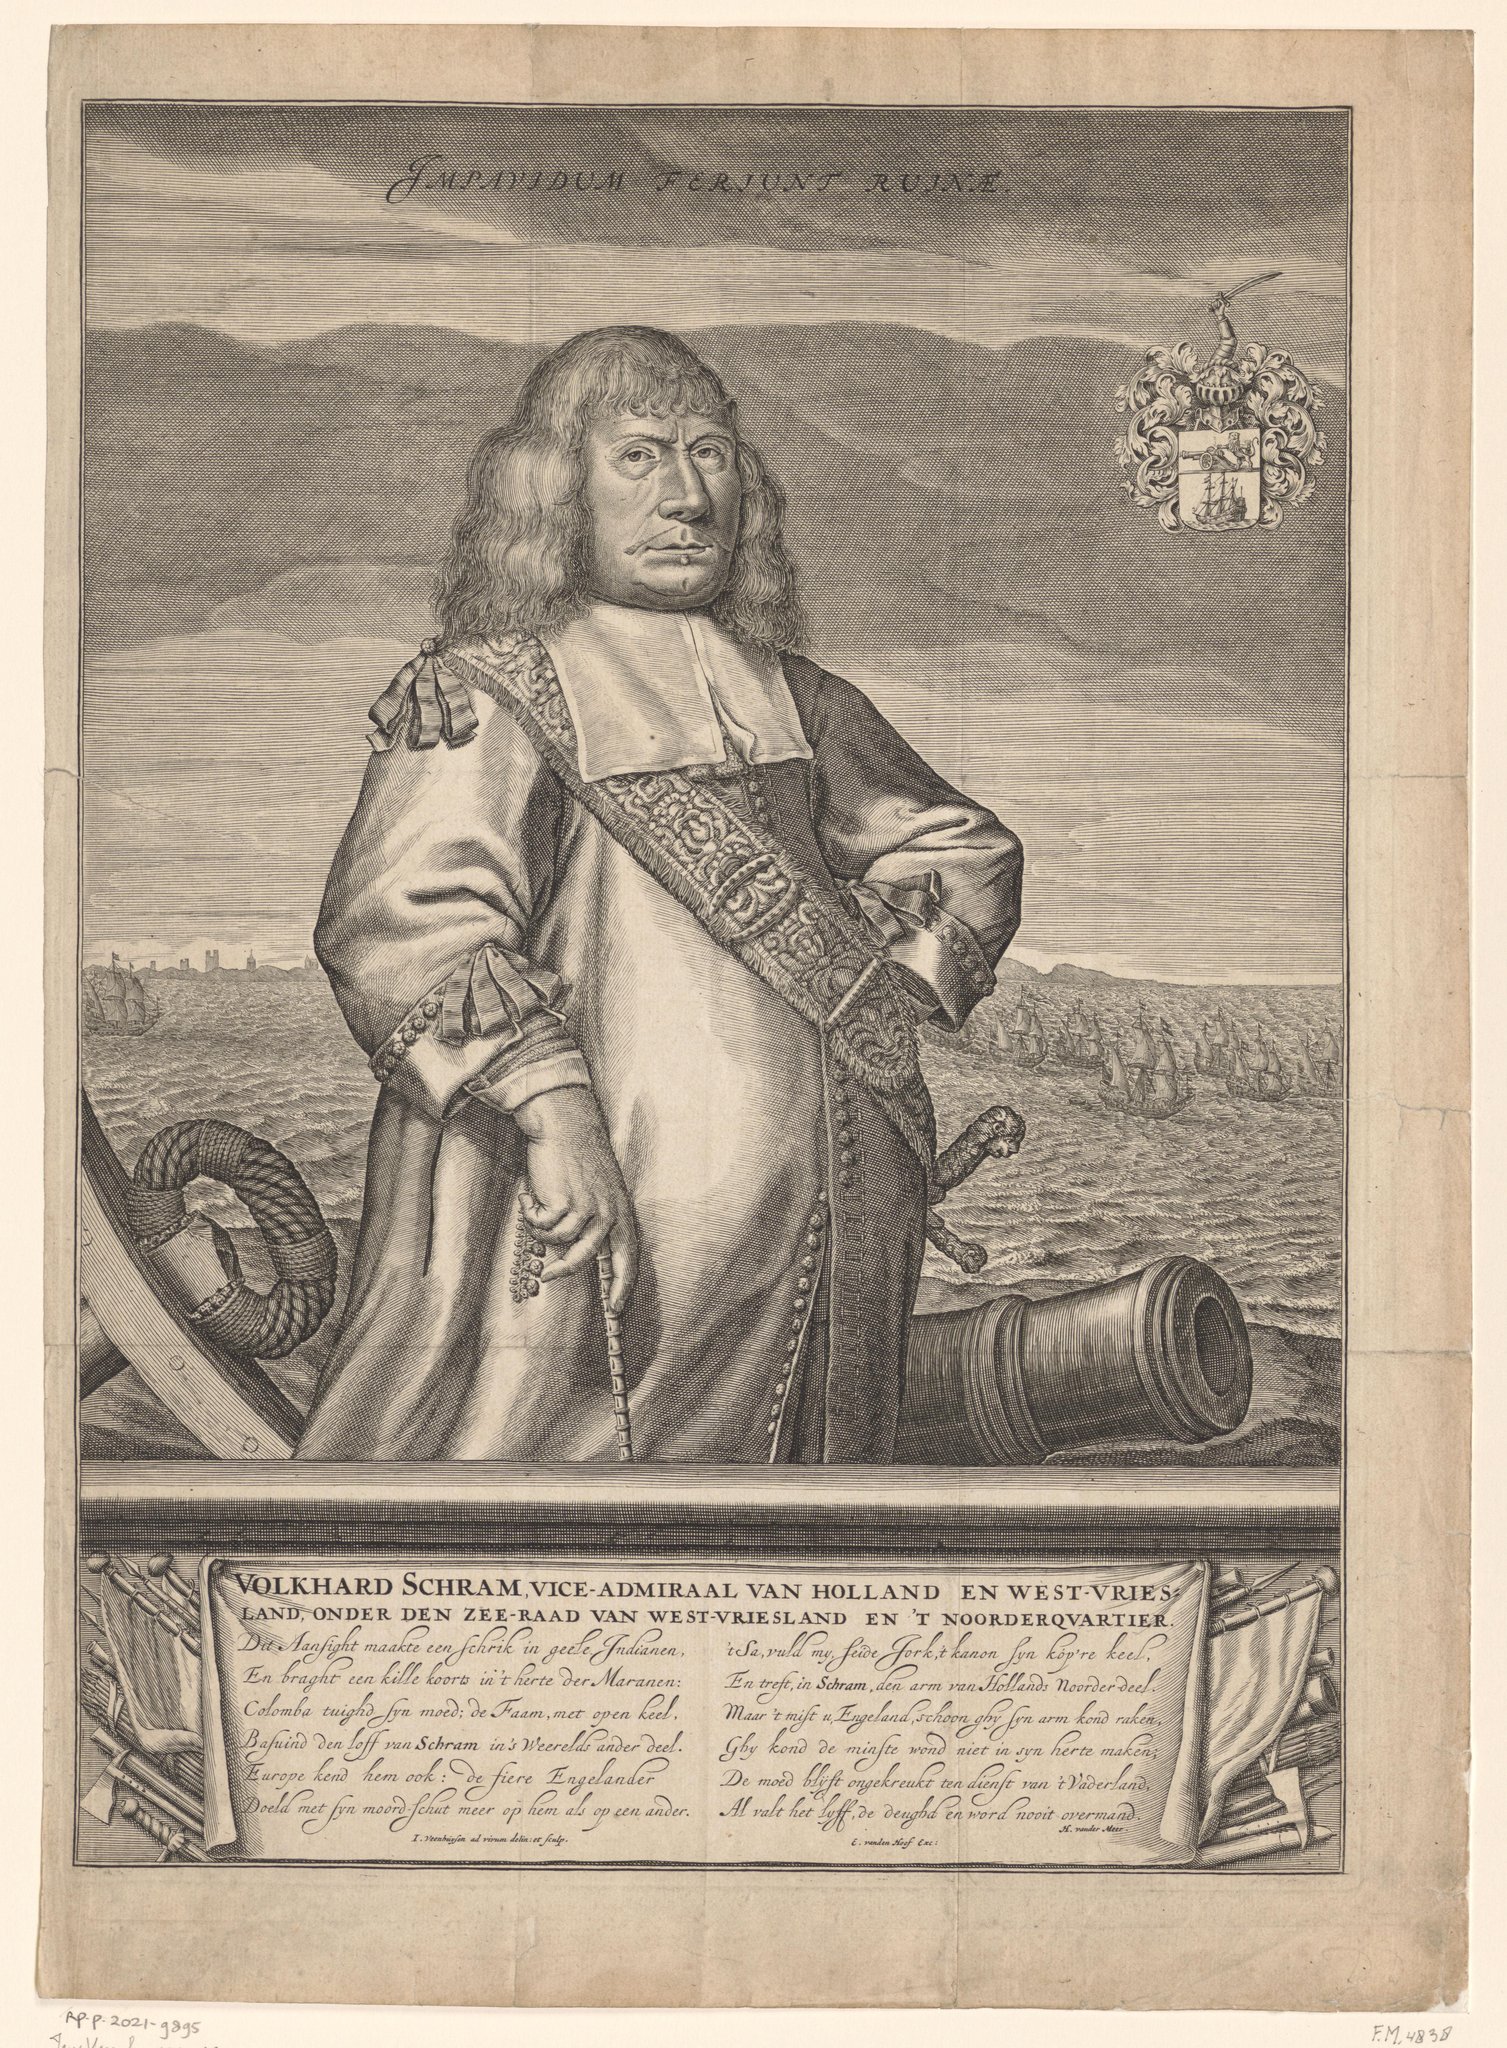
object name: print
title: Portret van Volkert Schram, Vice-admiraal van Holland en West-Friesland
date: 1655-1672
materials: paper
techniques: engraving, etching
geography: enkhuizen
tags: historical persons, ships (in general), firearms: cannon, armorial bearing, heraldry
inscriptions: collector's mark: Lugt 2228